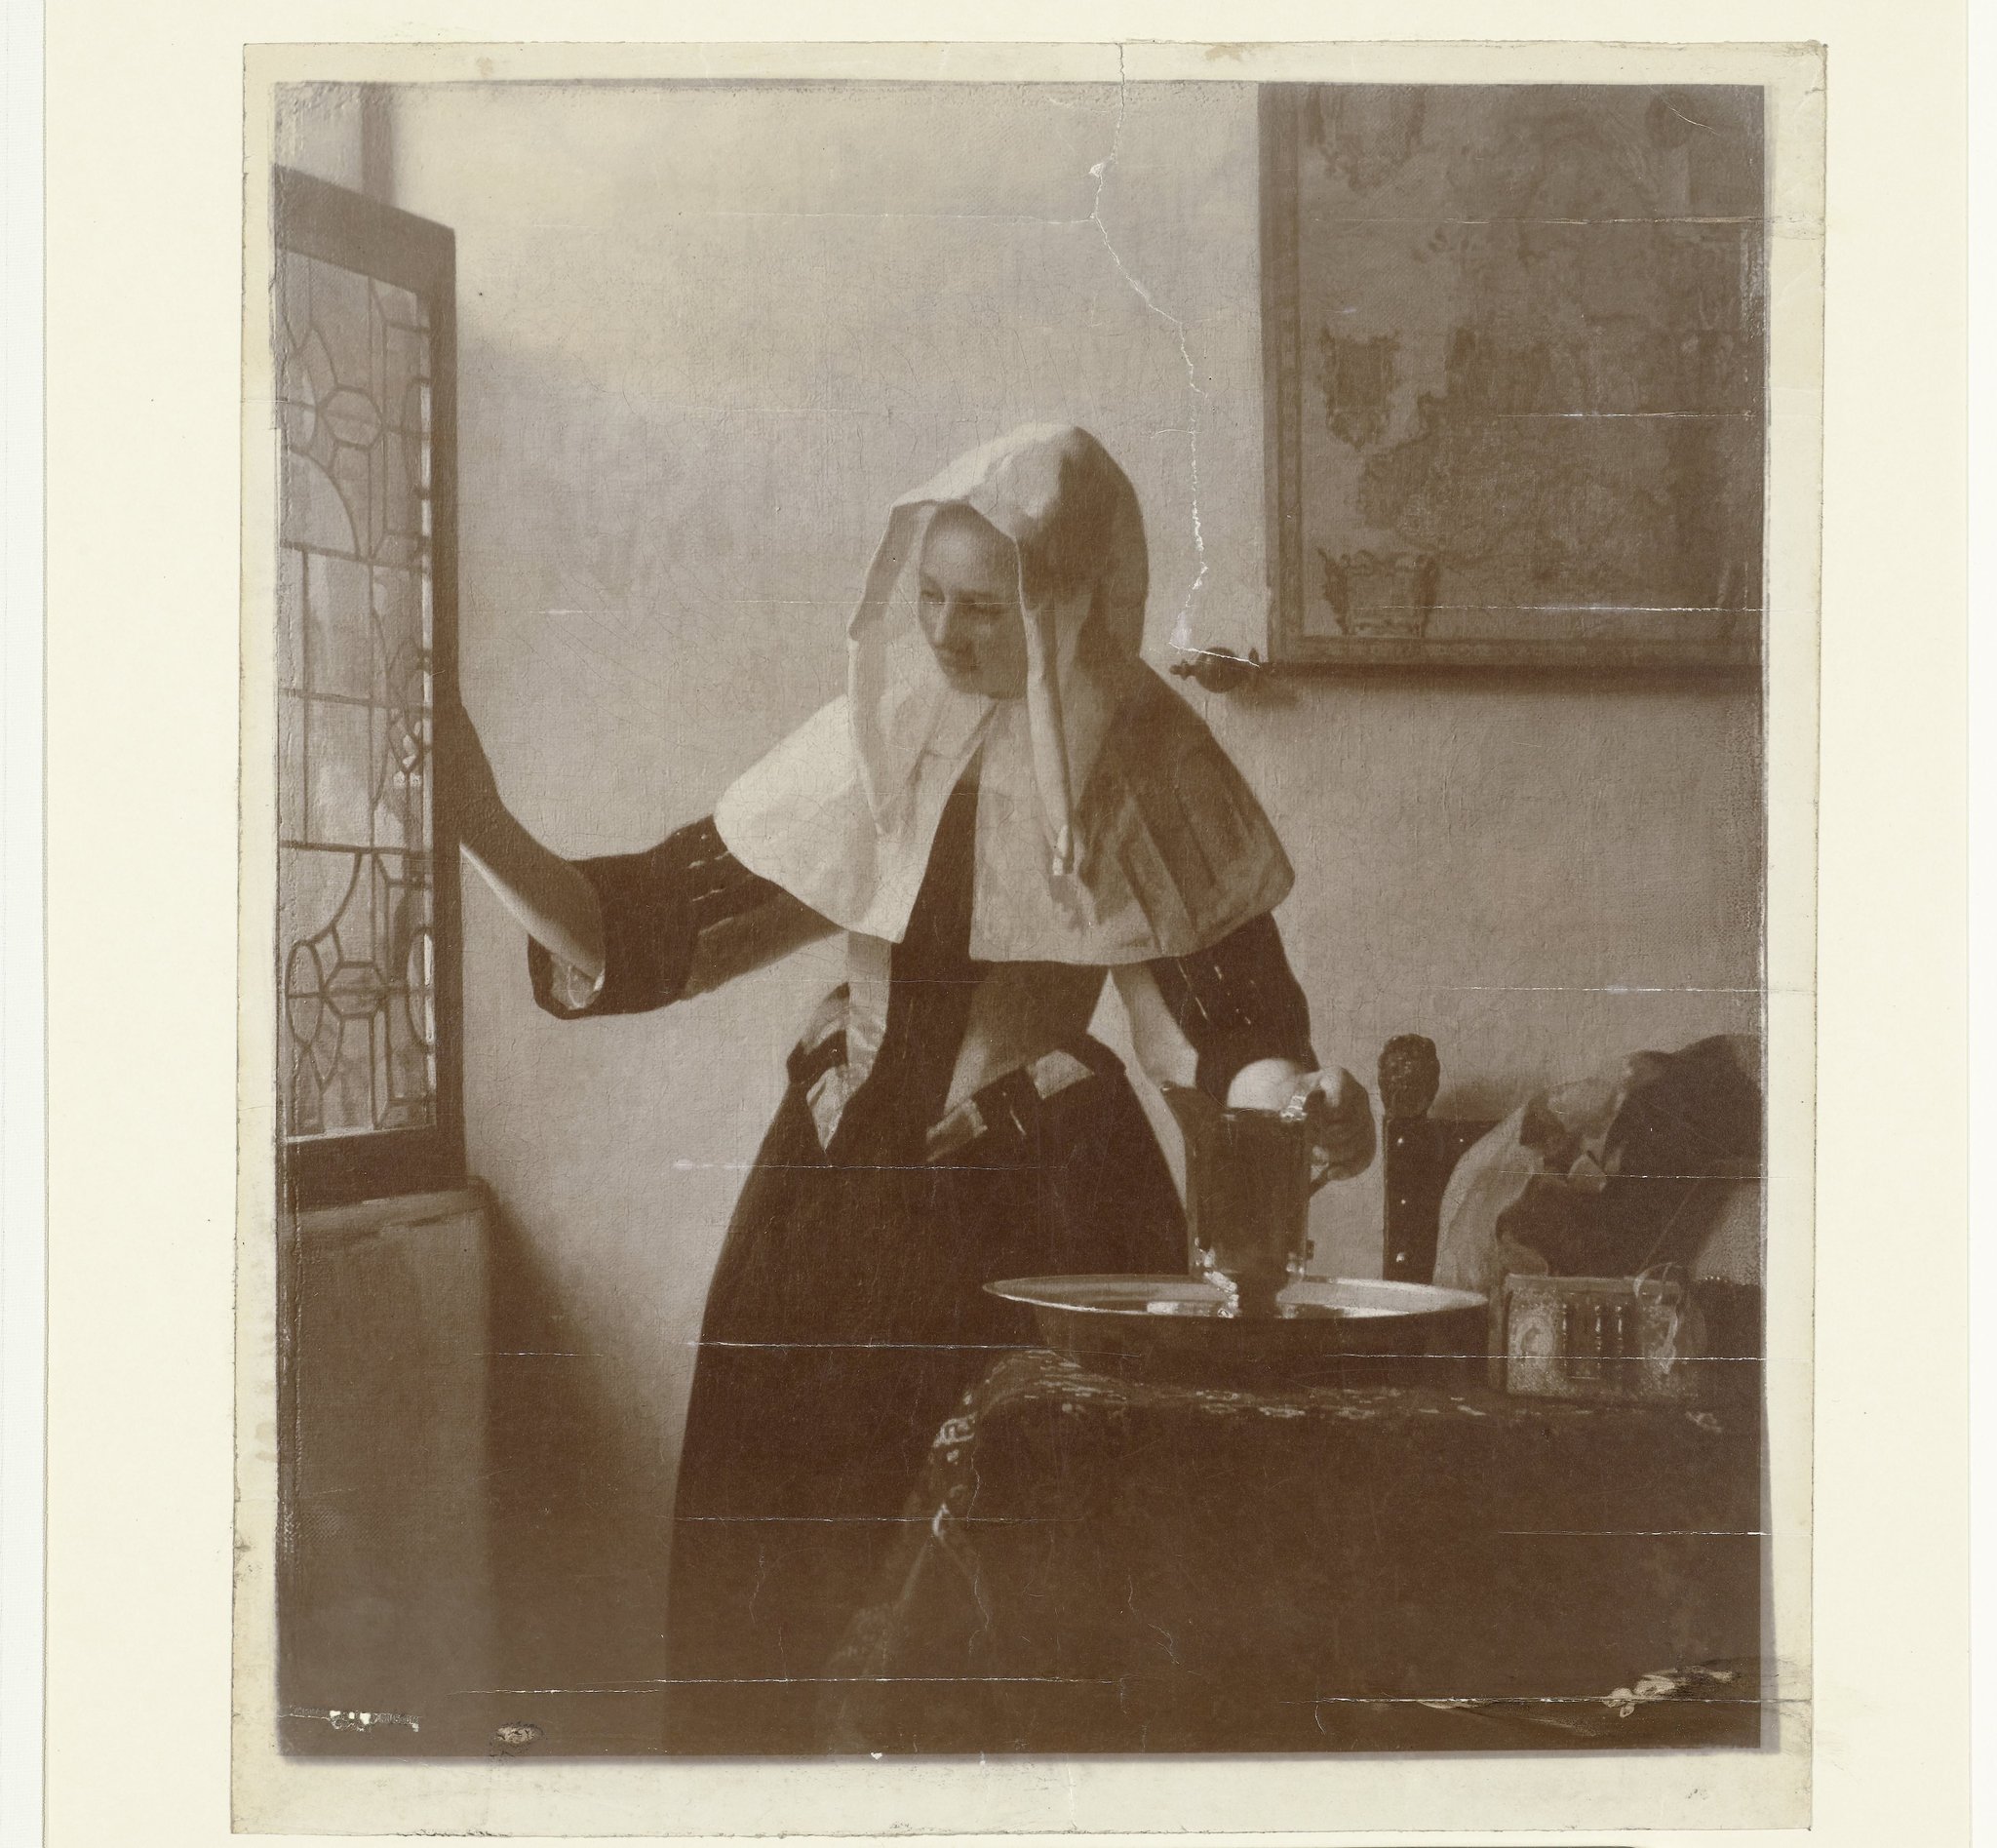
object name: photograph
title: Fotoreproductie Schilderij Vrouw met waterkan door Johannes Vermeer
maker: Anonymous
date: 1890-1910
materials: cardboard, paper, photographic support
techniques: albumen print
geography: amsterdam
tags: picture, painting